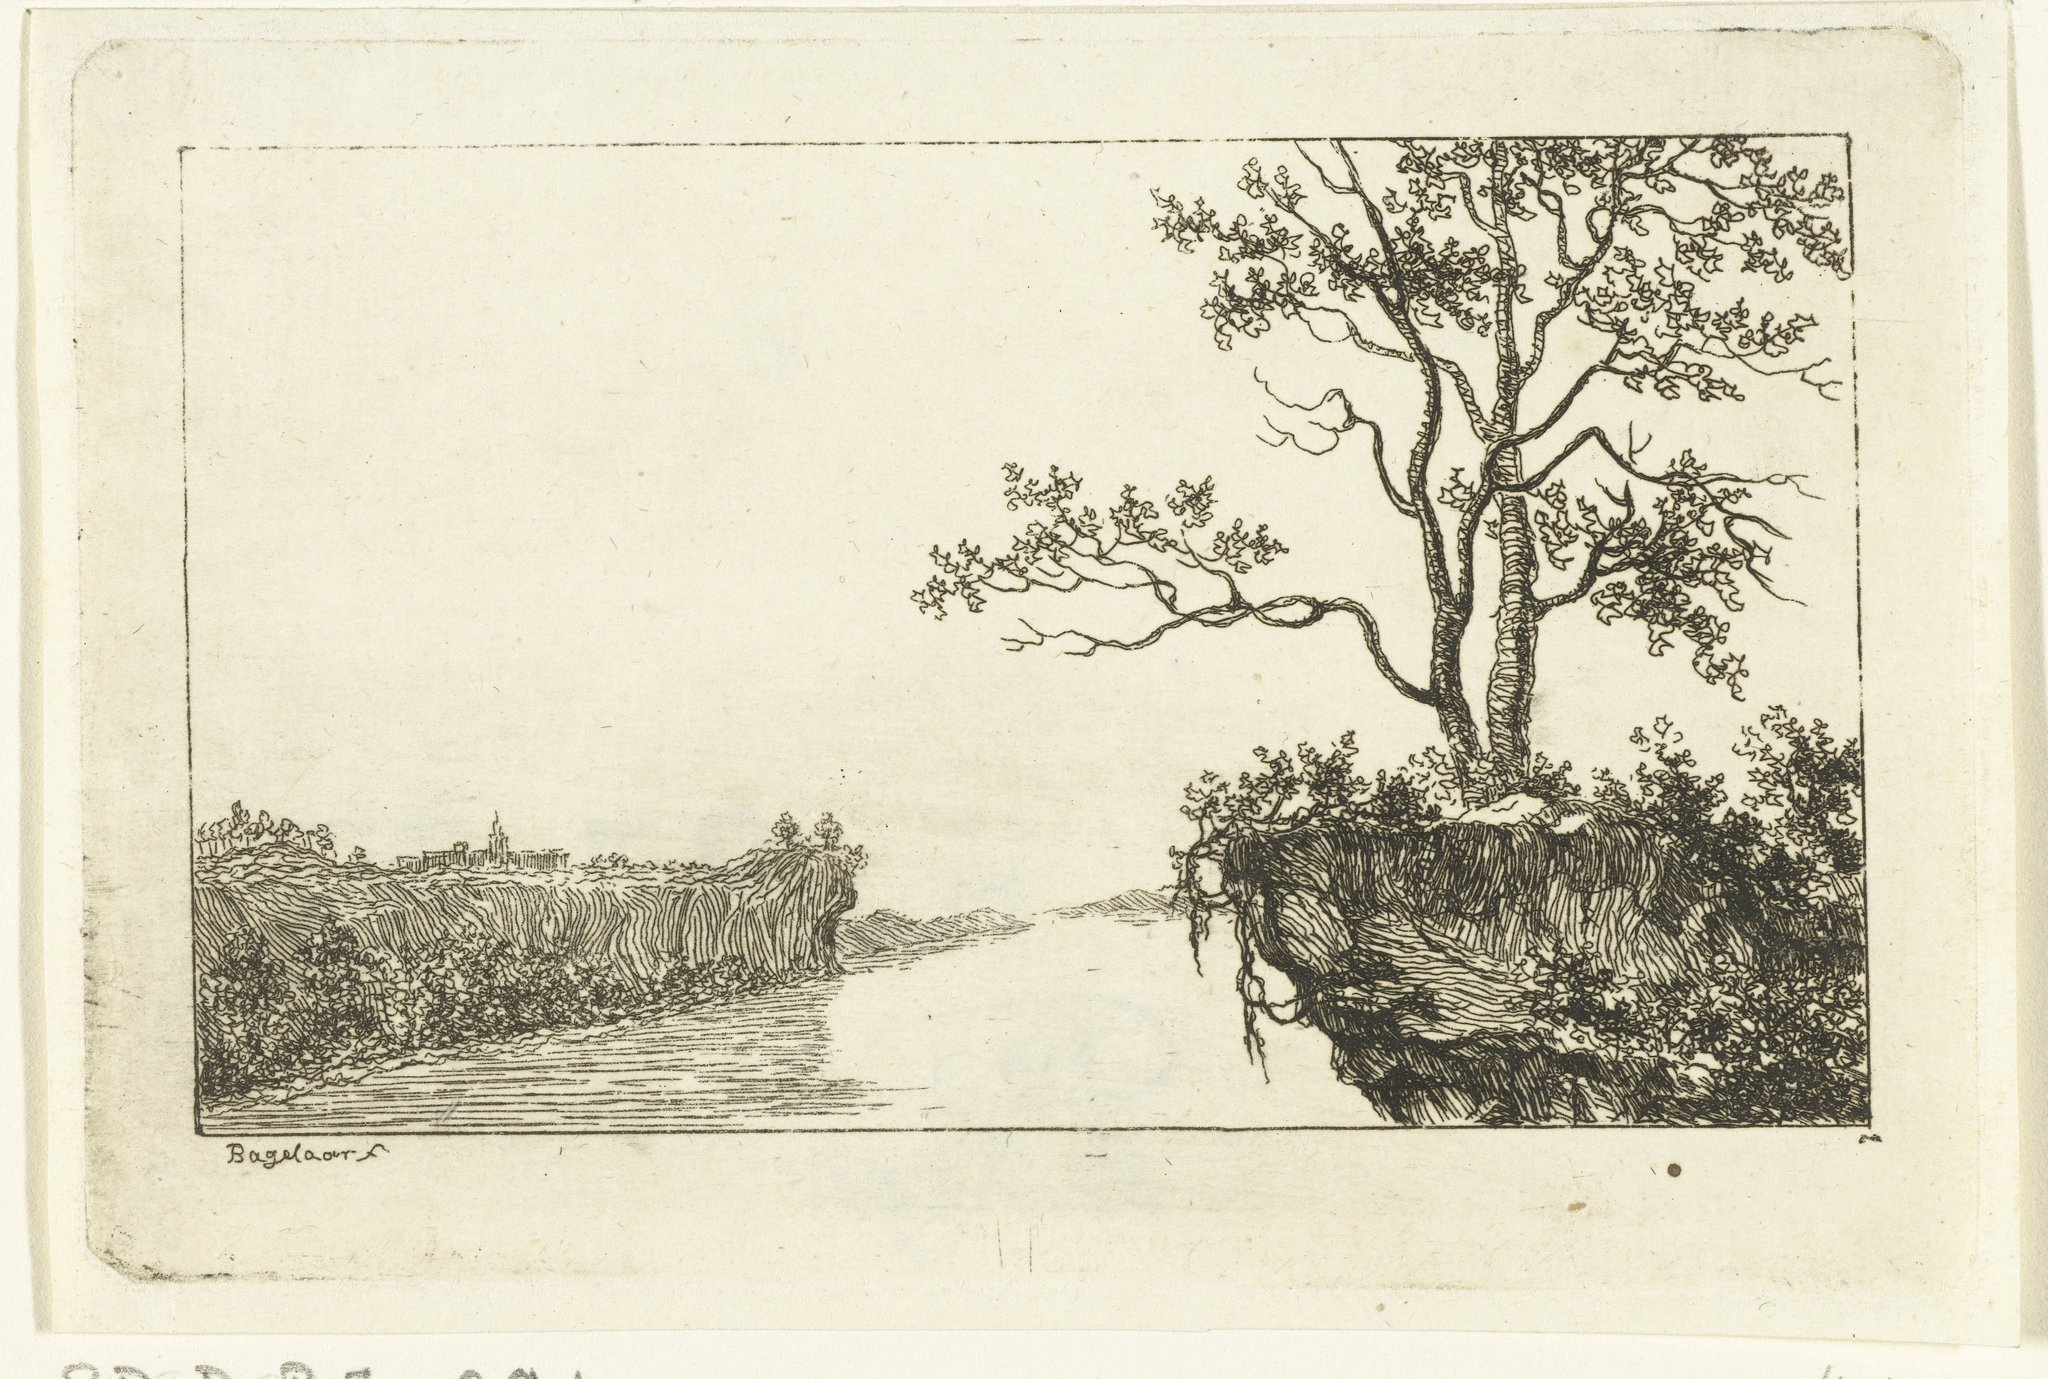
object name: print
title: Gezicht op de Donau bij Lintz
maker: ernst willem jan bagelaar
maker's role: draughtsman, print maker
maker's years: 1775-1837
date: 1798-1837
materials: paper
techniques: etching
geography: netherlands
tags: river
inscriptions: collector's mark: Lugt 2228